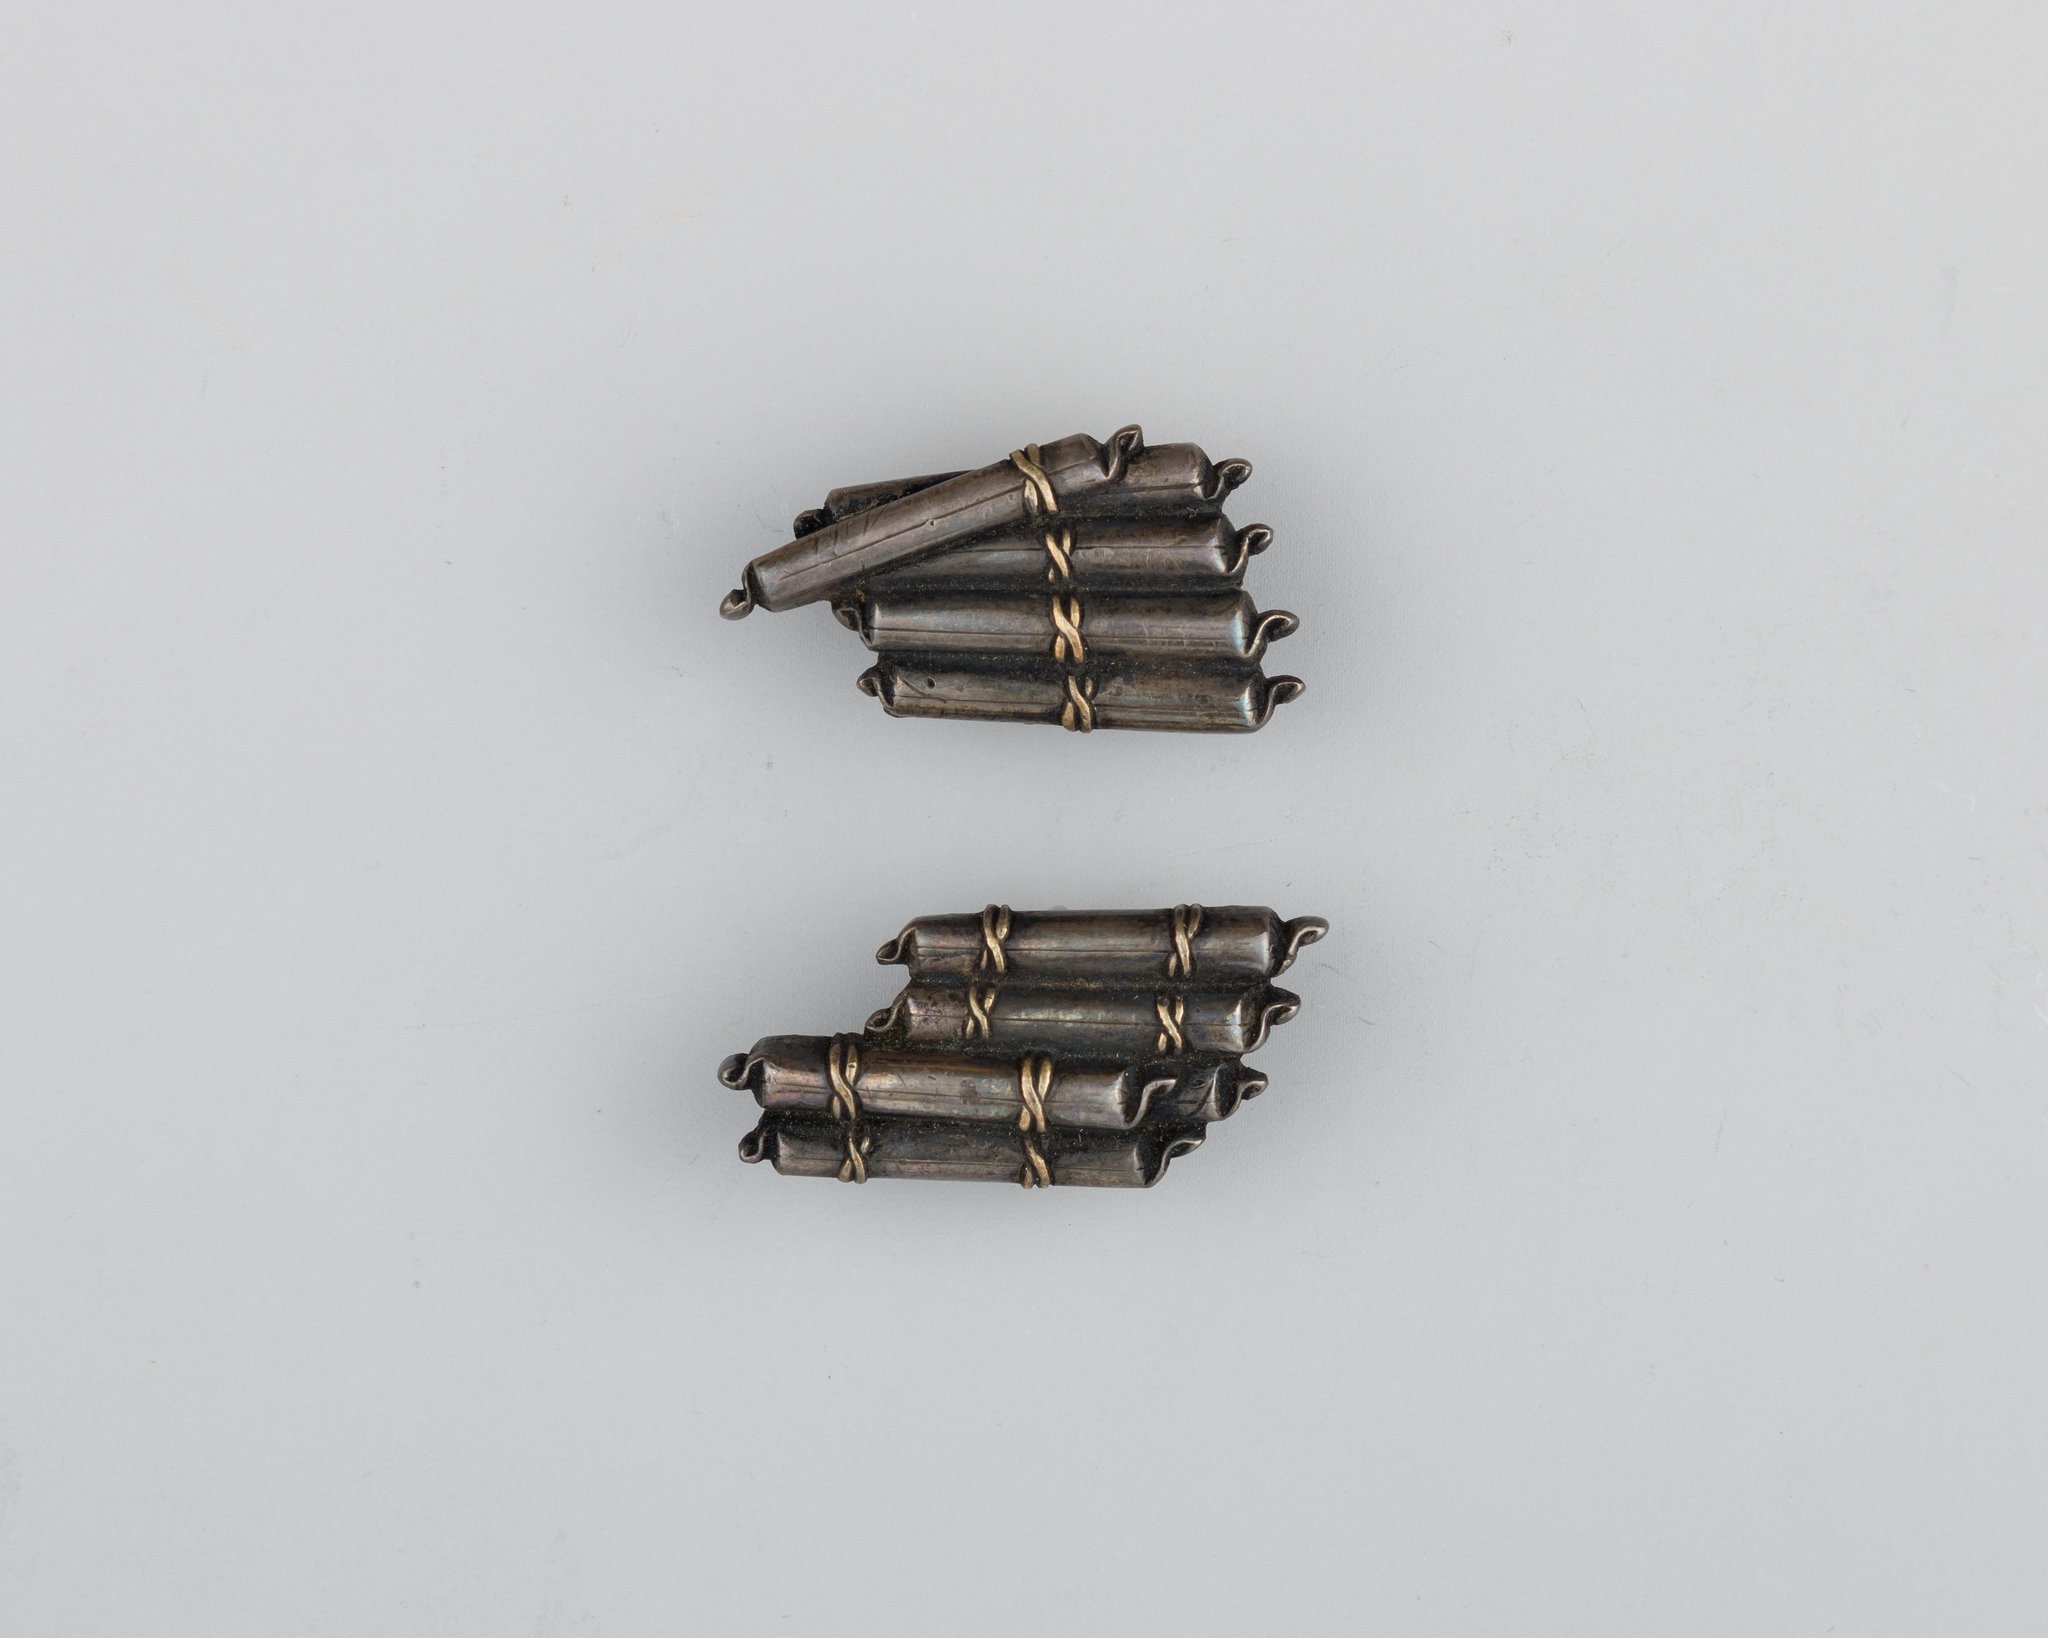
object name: pair of sword grip ornament menuki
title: Pair of Sword-Grip Ornaments (Menuki)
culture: japanese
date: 1701-1800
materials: gold, silver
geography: japan